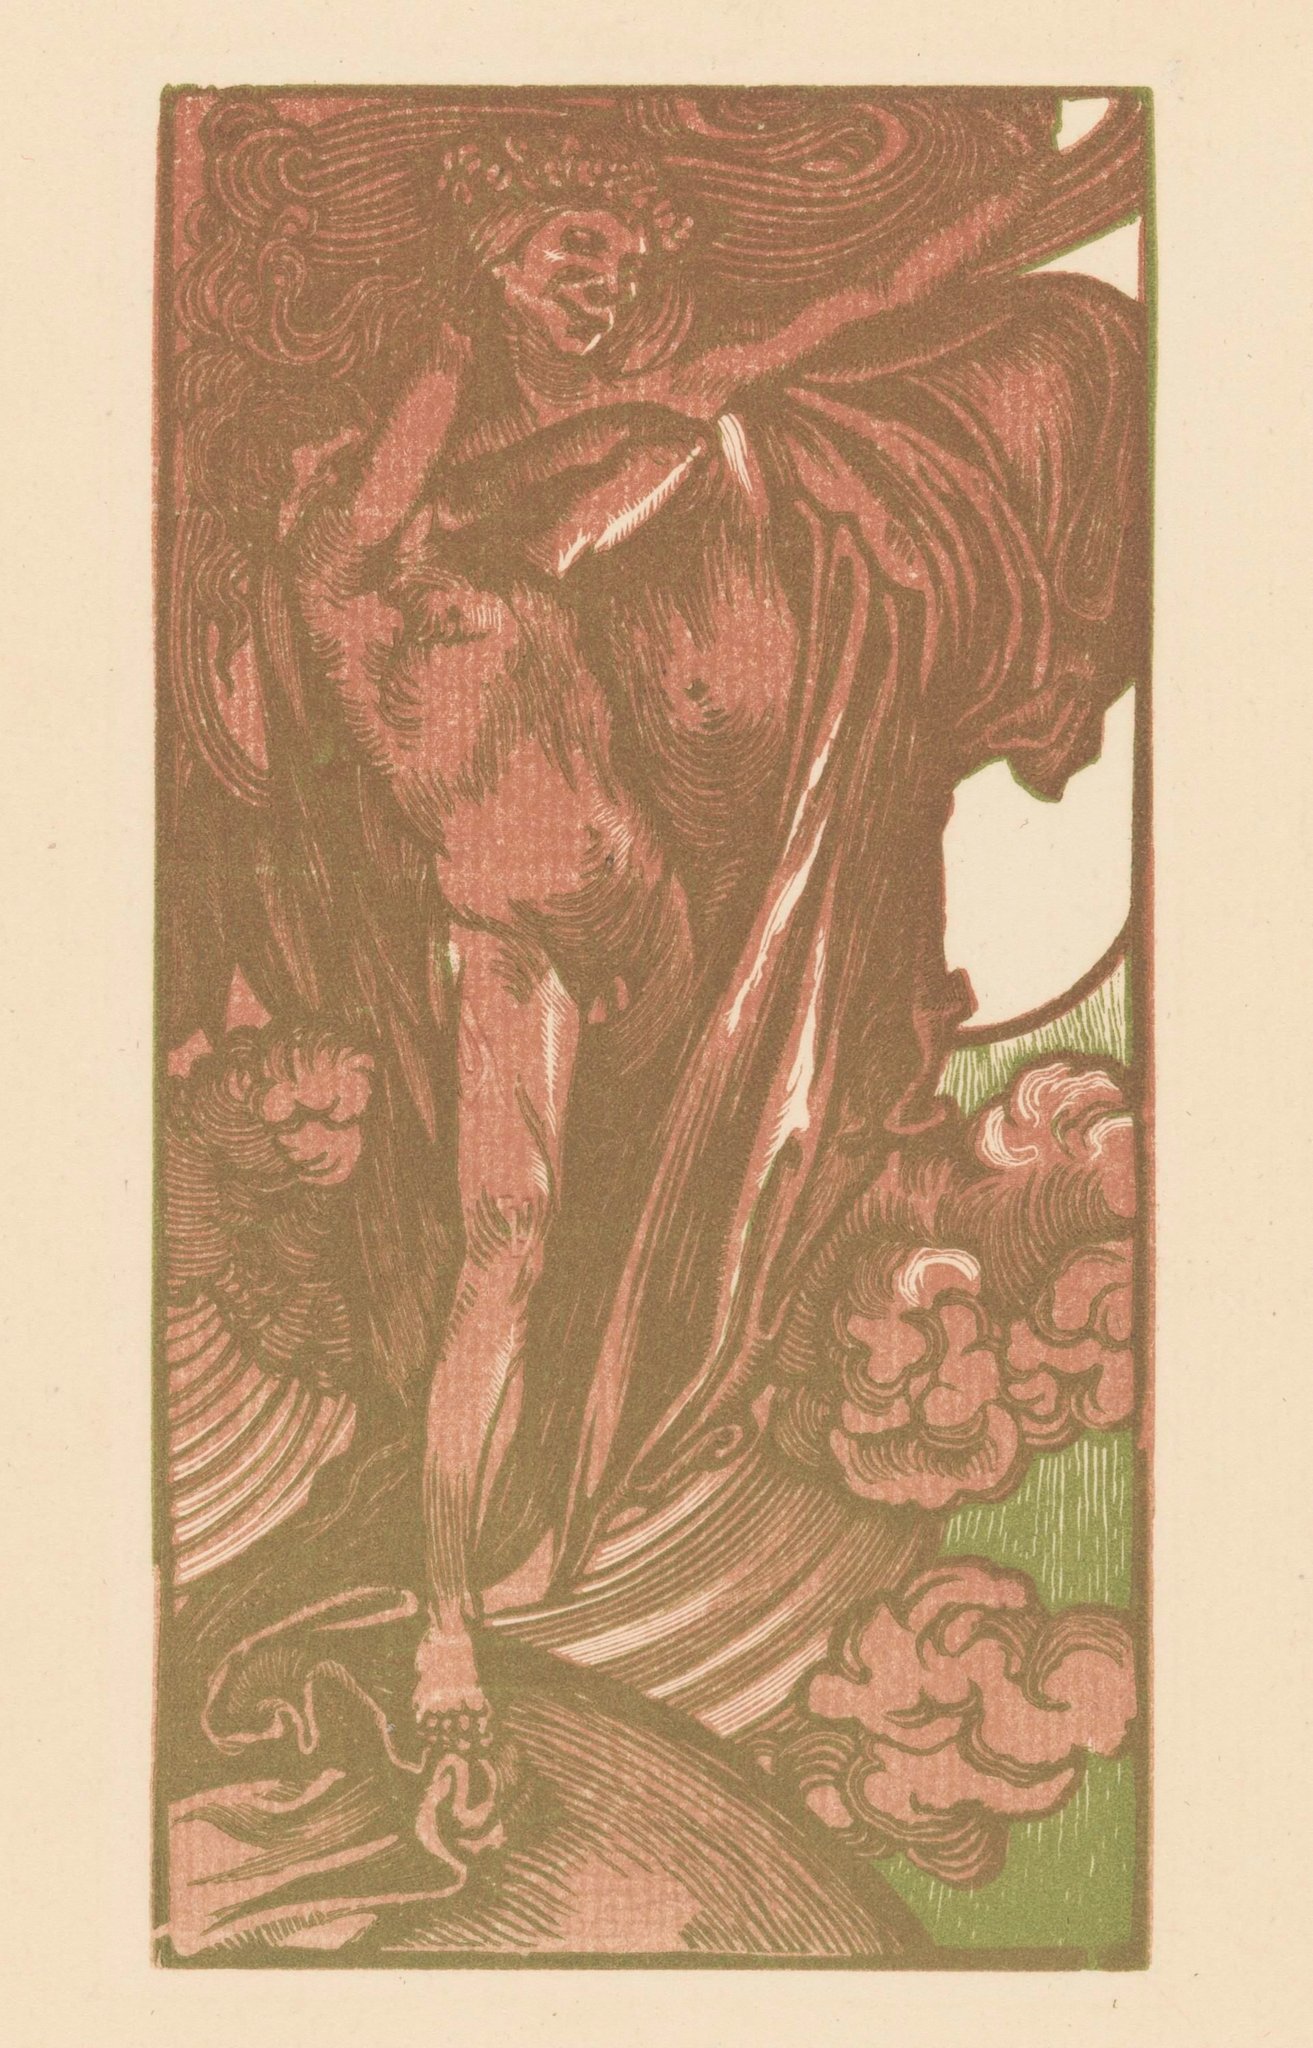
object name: print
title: Vrouw en jongen in de wolken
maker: johannes josephus aarts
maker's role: draughtsman, print maker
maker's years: 1871-1934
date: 1881-1934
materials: paper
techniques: woodcut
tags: (showing oneself) undressed, quasi-nude, clouds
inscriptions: collector's mark: Lugt 2228, collector's mark: Lugt 2760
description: Een naakte vrouw en jongen, beiden gedeeltelijk bedekt door de mantel van de vrouw. Om hen heen verschillende wolken. De vrouw draagt een bloemenkrans in haar golvende haar, mogelijk stelt ze een genius voor.